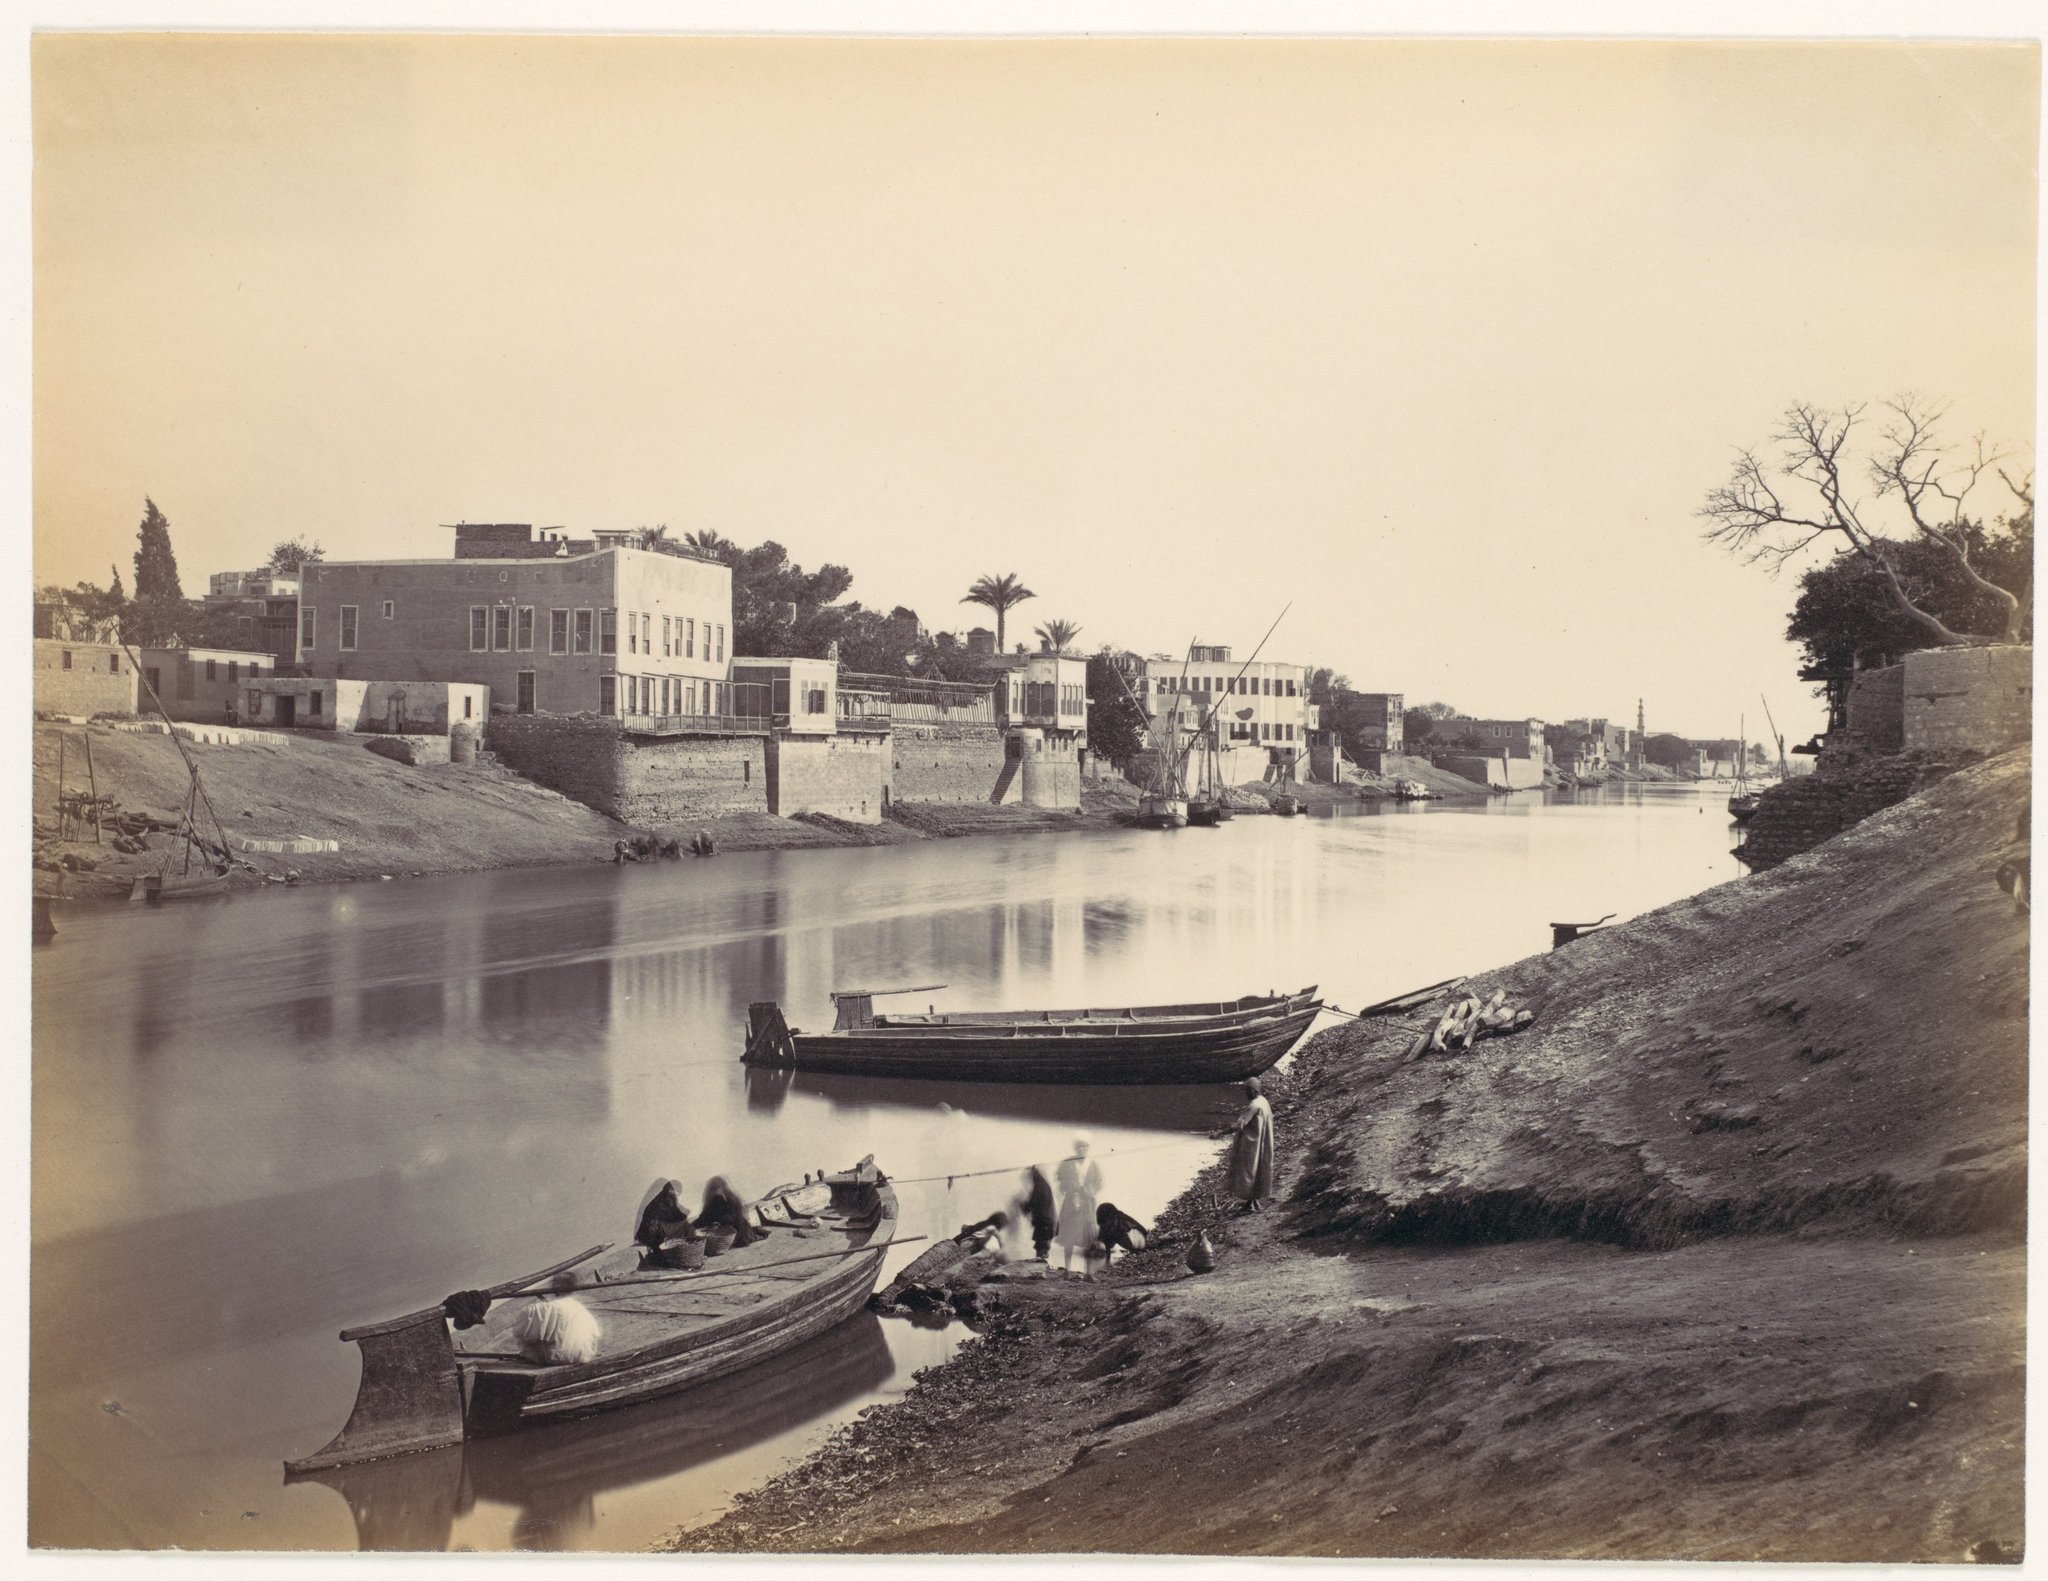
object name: photograph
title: Banks of the Nile at Cairo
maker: francis frith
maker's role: publisher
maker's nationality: english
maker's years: 1822-1898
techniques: albumen silver print, glass negative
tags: rivers,boats